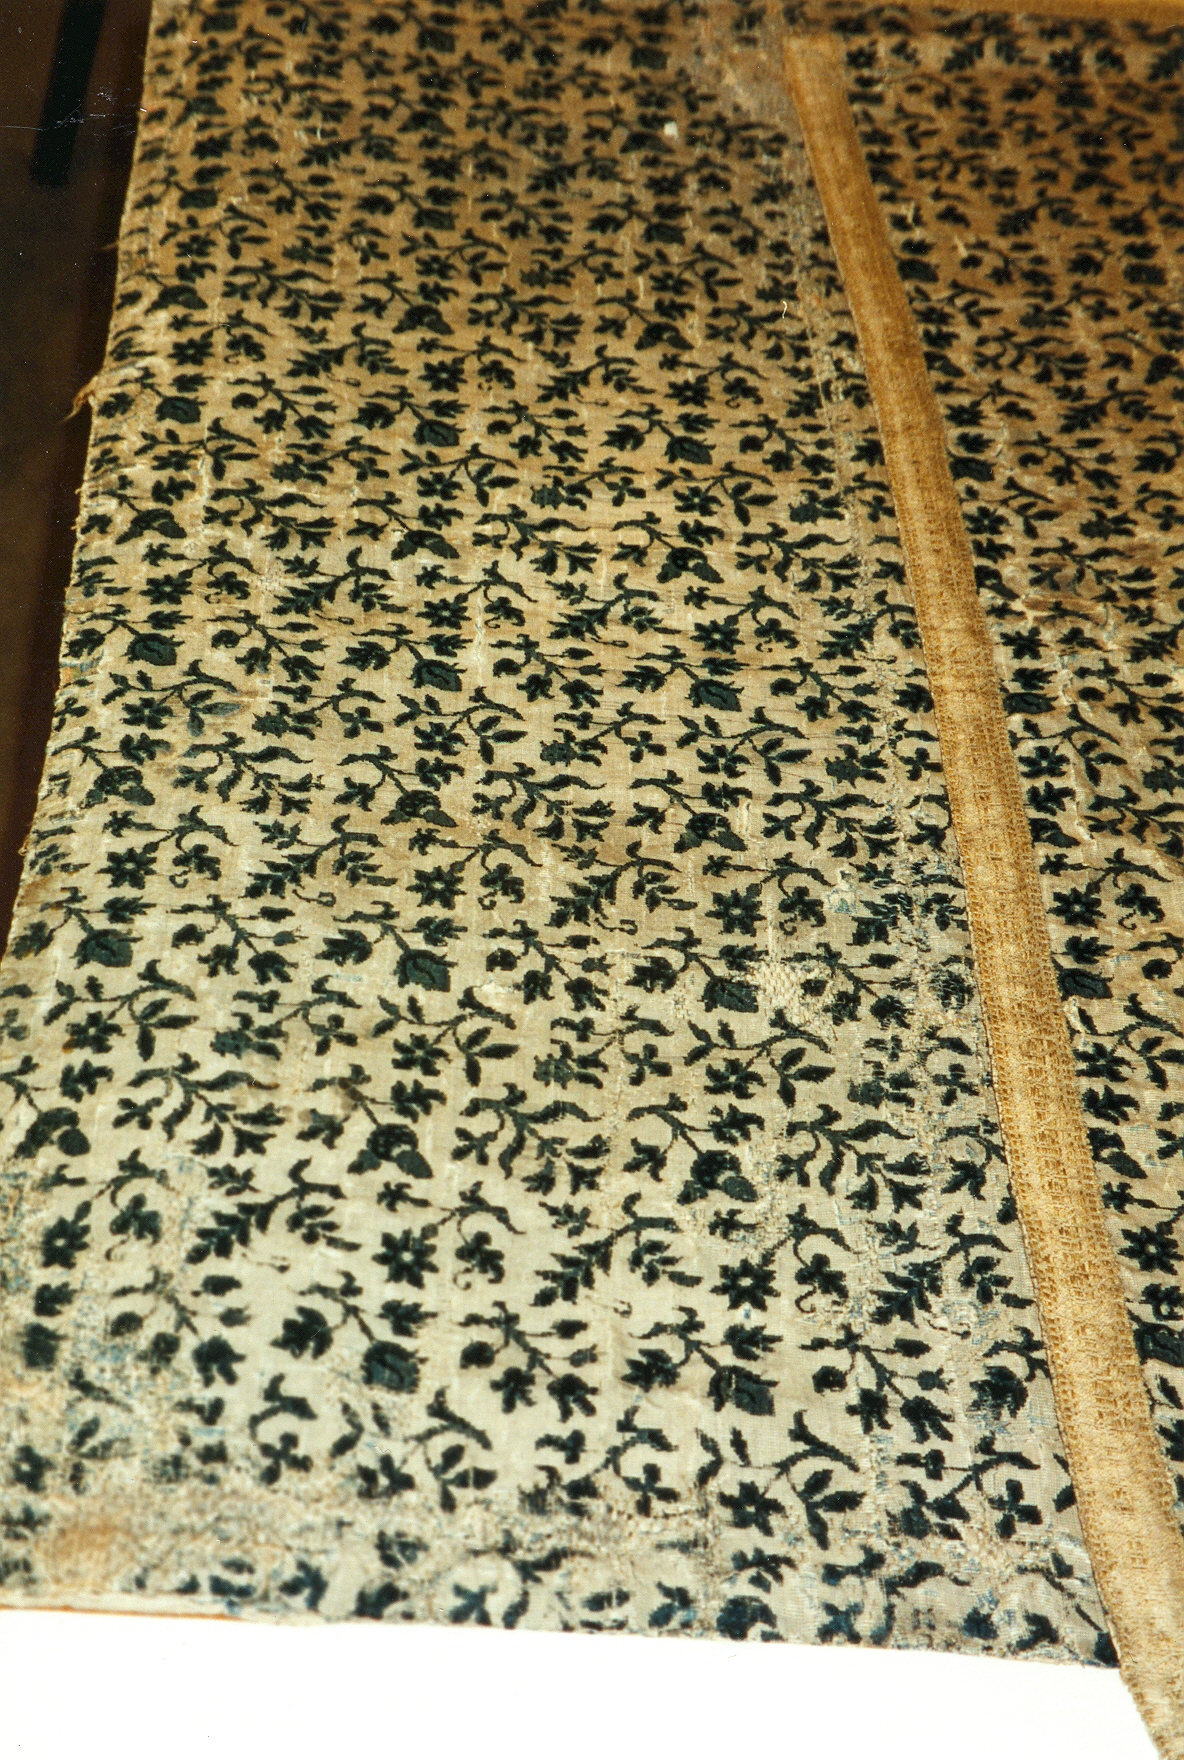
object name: textile panel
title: Panel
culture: french or italian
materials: linen, silk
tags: flowers